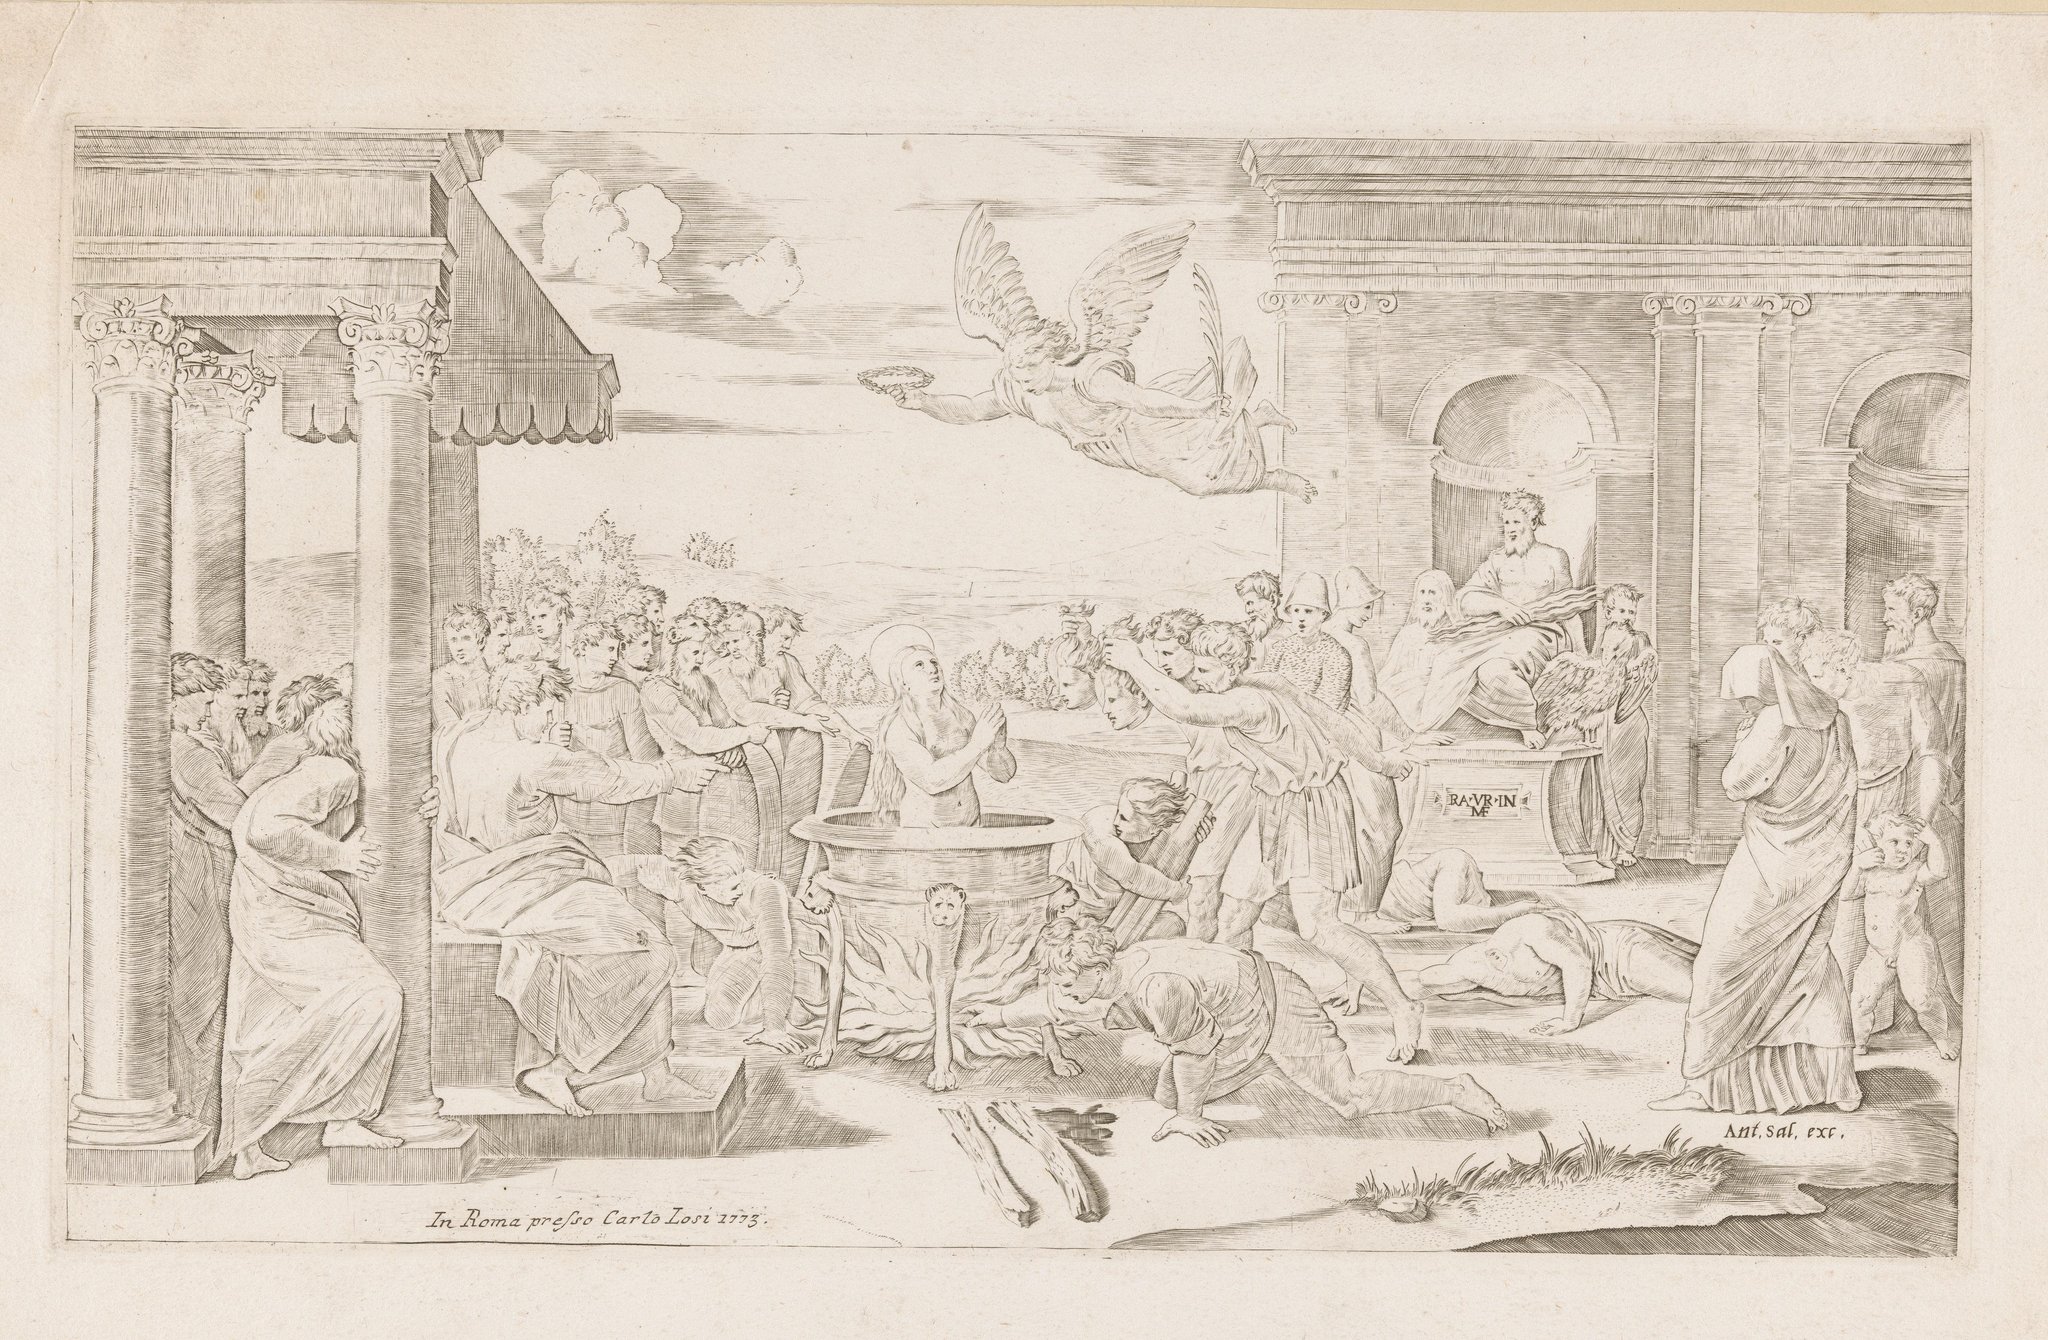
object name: print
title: Martelaarschap van de heilige Cecilia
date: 1773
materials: paper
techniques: engraving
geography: rome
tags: st. cecilia is put in a cauldron of boiling oil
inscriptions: collector's mark: Lugt 2228, collector's mark: Lugt 2028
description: De heilige Cecilia staat naakt in een pot met kokende olie en kijkt met gevouwen handen omhoog. Boven haar vliegt een engel met lauwerkrans en palmtak. Twee mannen tonen Cecilia de afgehakte hoofden van haar echtgenoot en zwager. Links zit onder een baldakijn een Romeinse prefect. Midden achter een standbeeld van Jupiter op een sokkel.